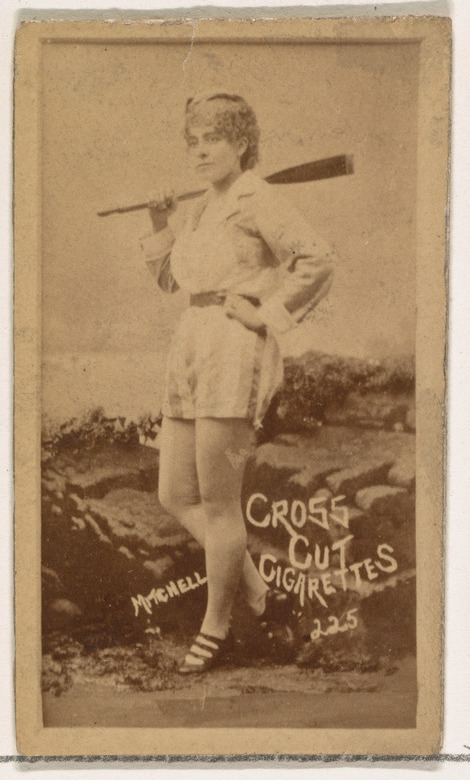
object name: print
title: Card Number 225, Mitchell, from the Actors and Actresses series (N145-1) issued by Duke Sons & Co. to promote Cross Cut Cigarettes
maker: w. duke, sons & co.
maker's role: publisher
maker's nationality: american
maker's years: 1870-1920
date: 1880-1889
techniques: albumen silver print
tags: portraits,women,actresses